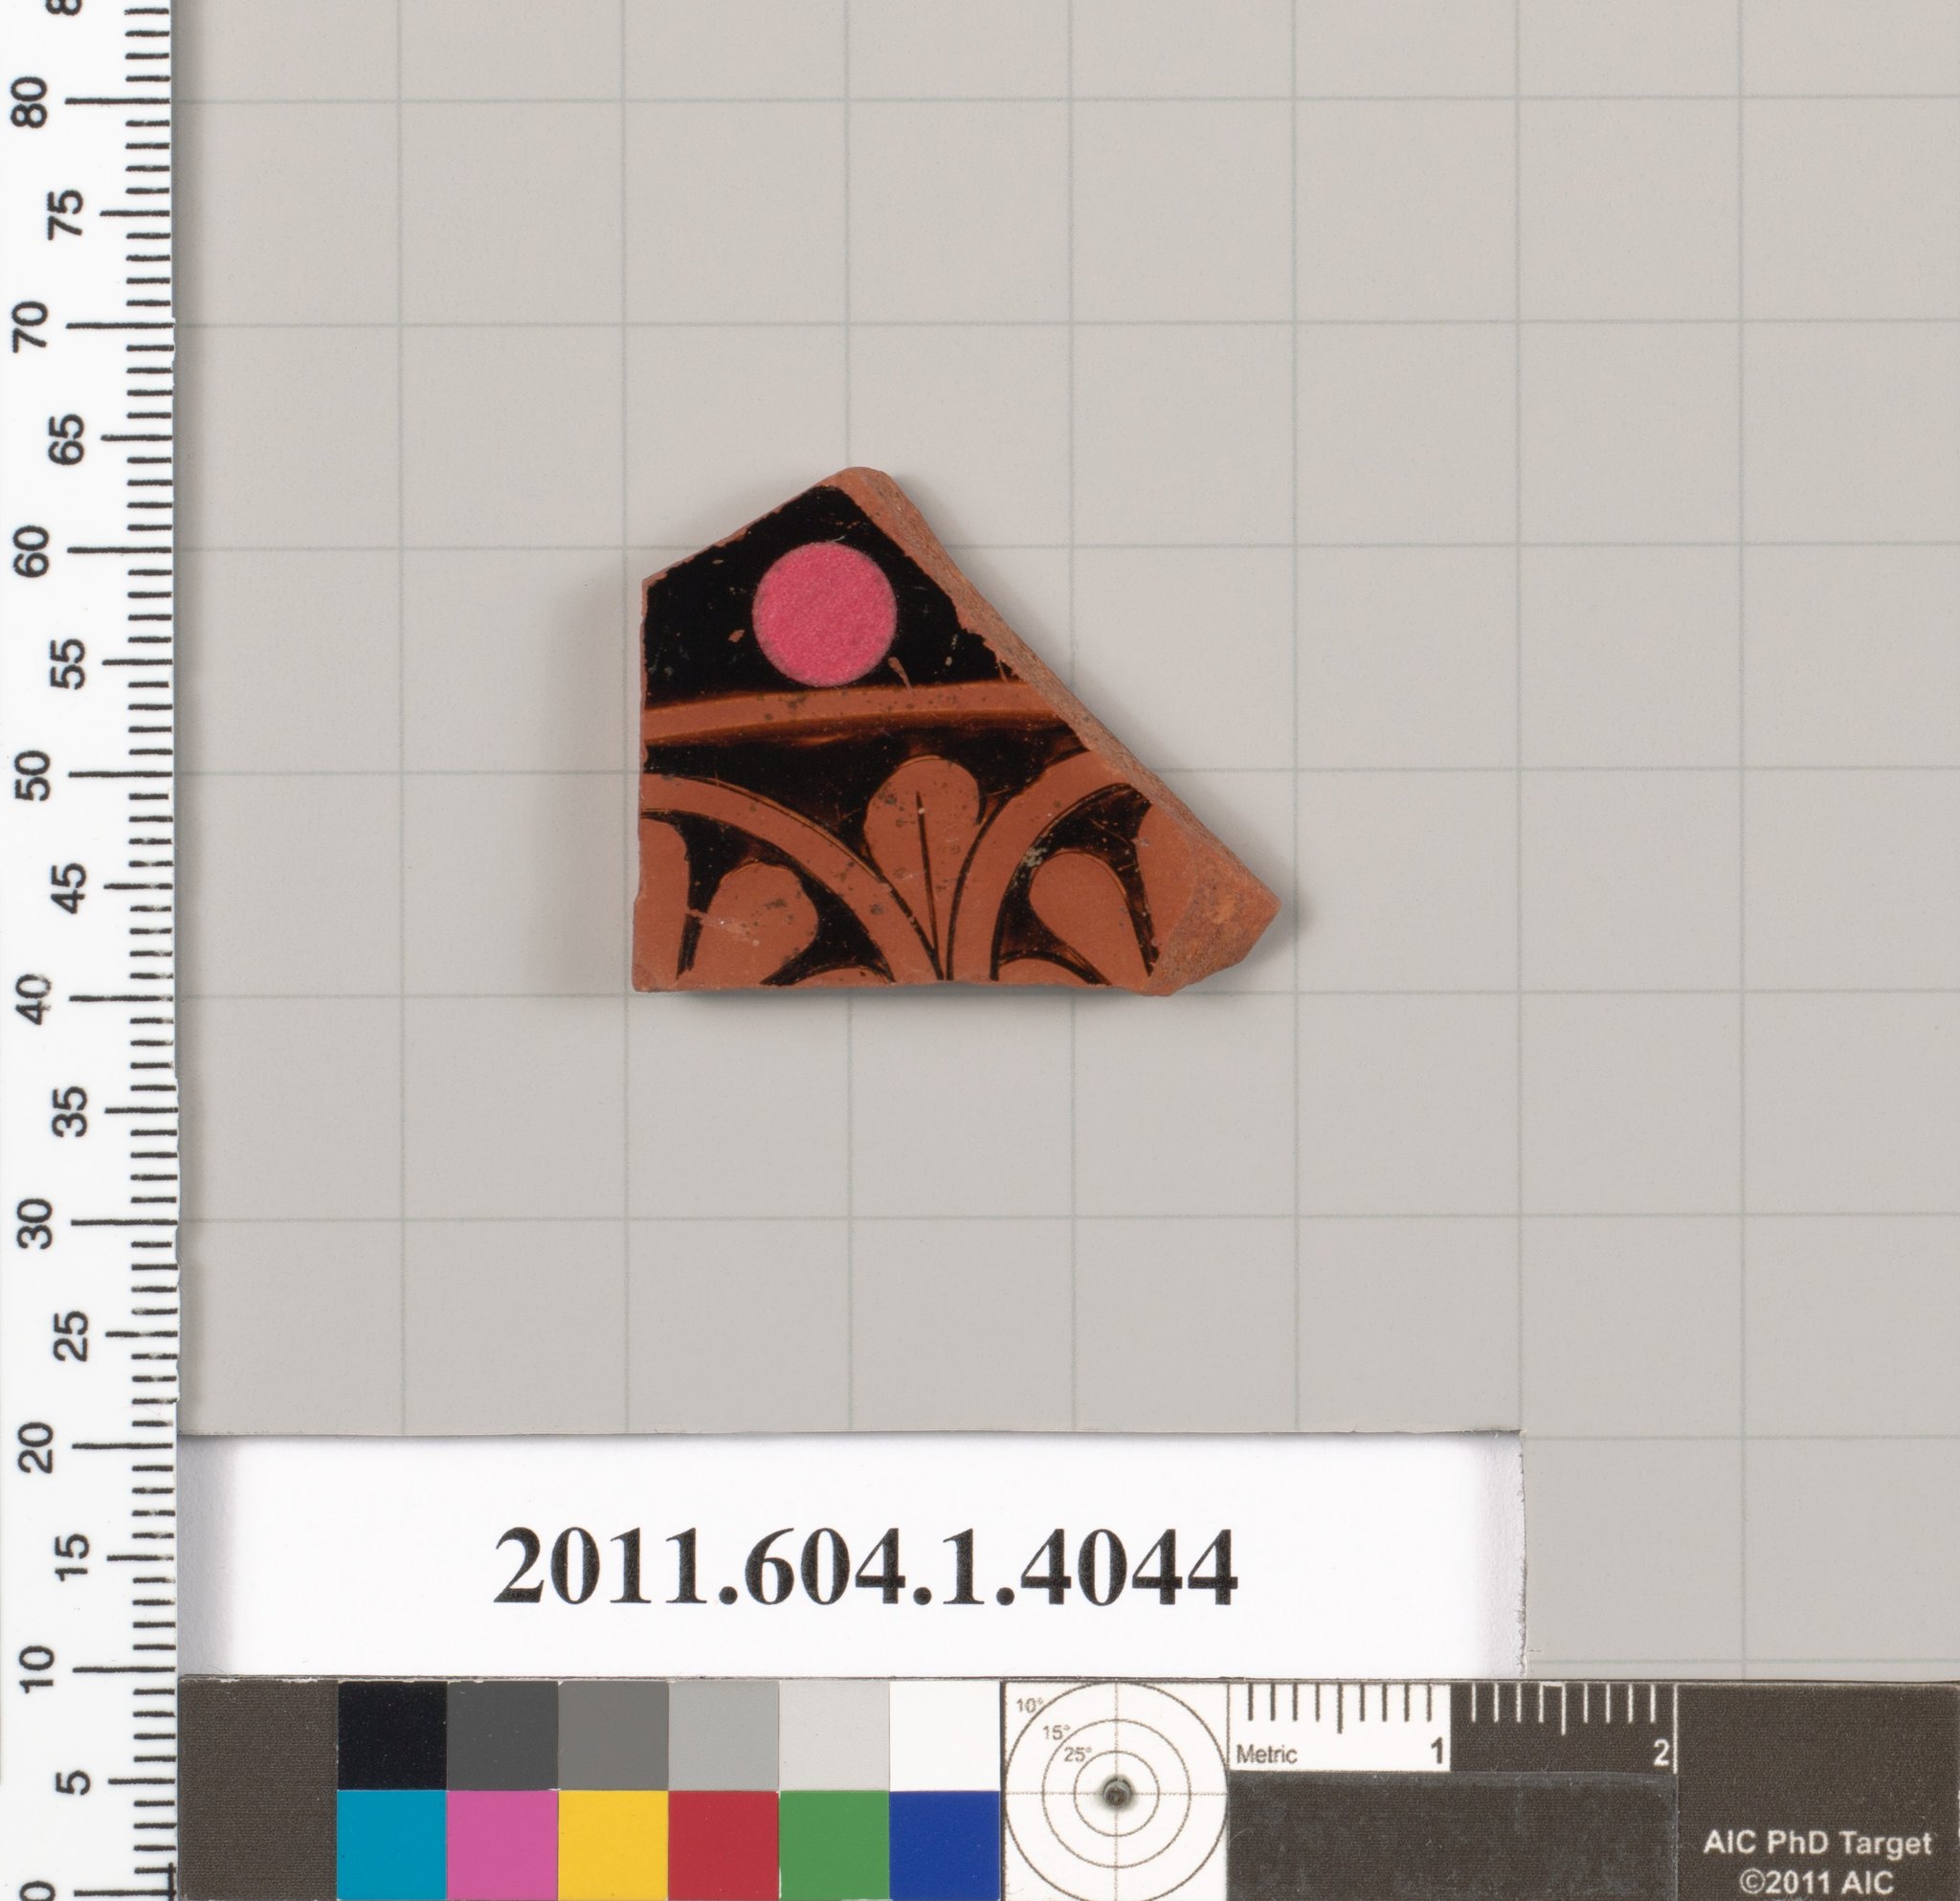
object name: kylix fragment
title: Terracotta fragment of a kylix (drinking cup)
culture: greek, attic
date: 534-468 BCE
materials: terracotta